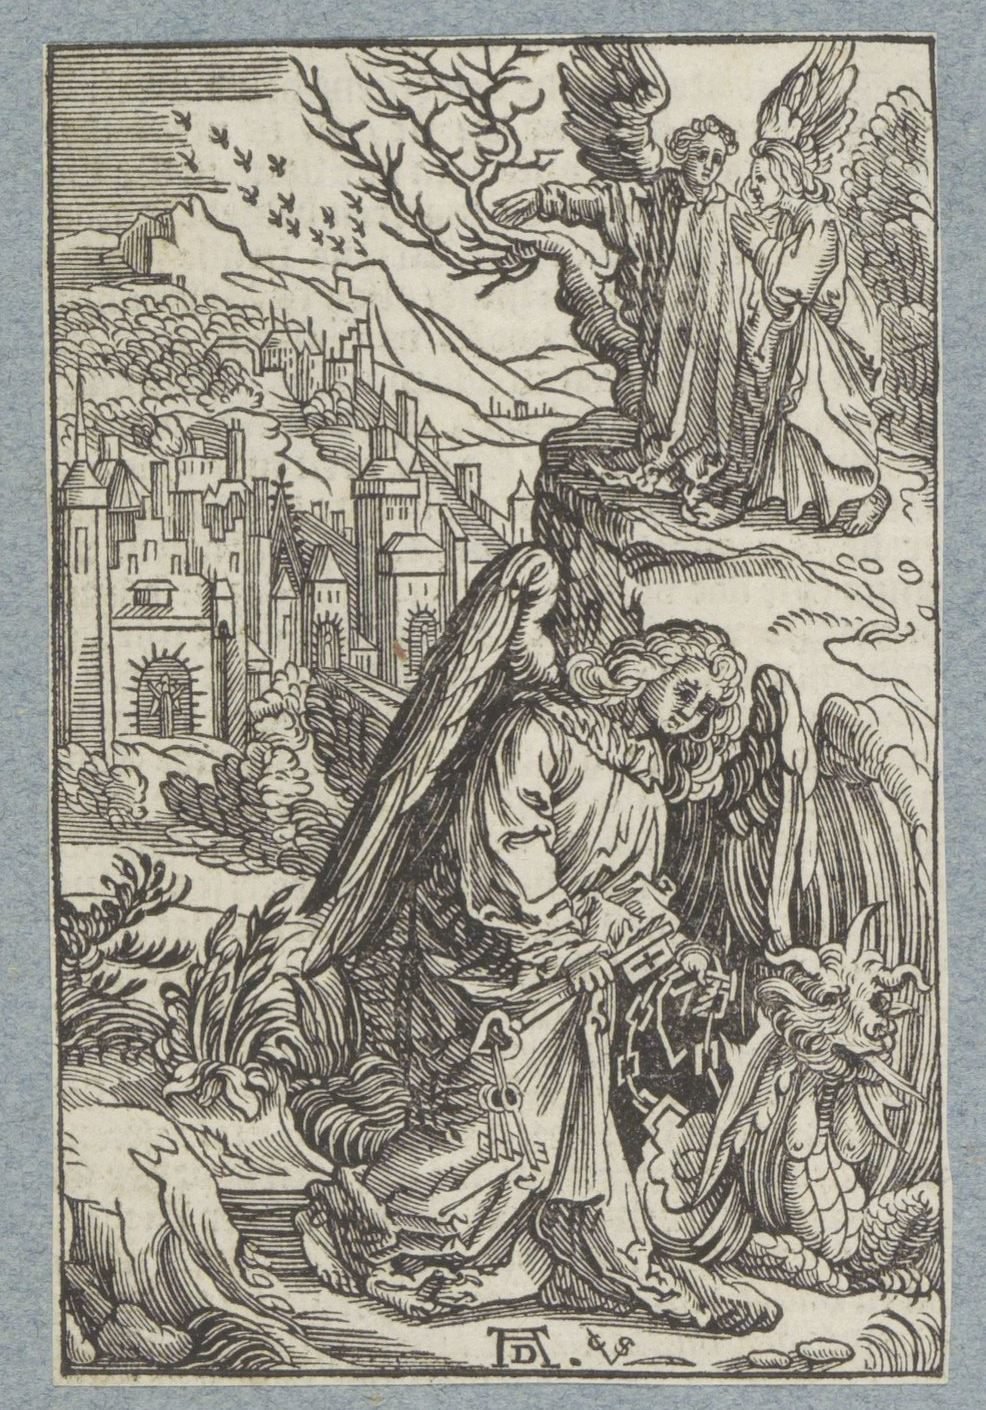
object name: album leaf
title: Een engel werpt een draak in een put; een engel toont Johannes de Evangelist het nieuwe Jeruzalem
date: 1629-1646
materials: paper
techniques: letterpress printing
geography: amsterdam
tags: an angel shows john the new (heavenly) jerusalem coming down from heaven; sometimes christ is shown leading his lambs to the city, an angel with a key and a chain binds the dragon (satan) and casts him into the pit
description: De prent is afkomstig uit een van de uitgaven van P.J. Paets uit Amsterdam. De prent wordt mogelijk al gebruikt voor: Der Zielen Lust-hof. Leuven, I.Jacbosz voor P.J. Paets [= Amsterdam, P.J. Paets], 1629. Ze komt in ieder geval voor in: Het Nieuwe Testament ons Salichmaeckers Jesu Christi. Amsterdam, P.J. Paets, 1646.